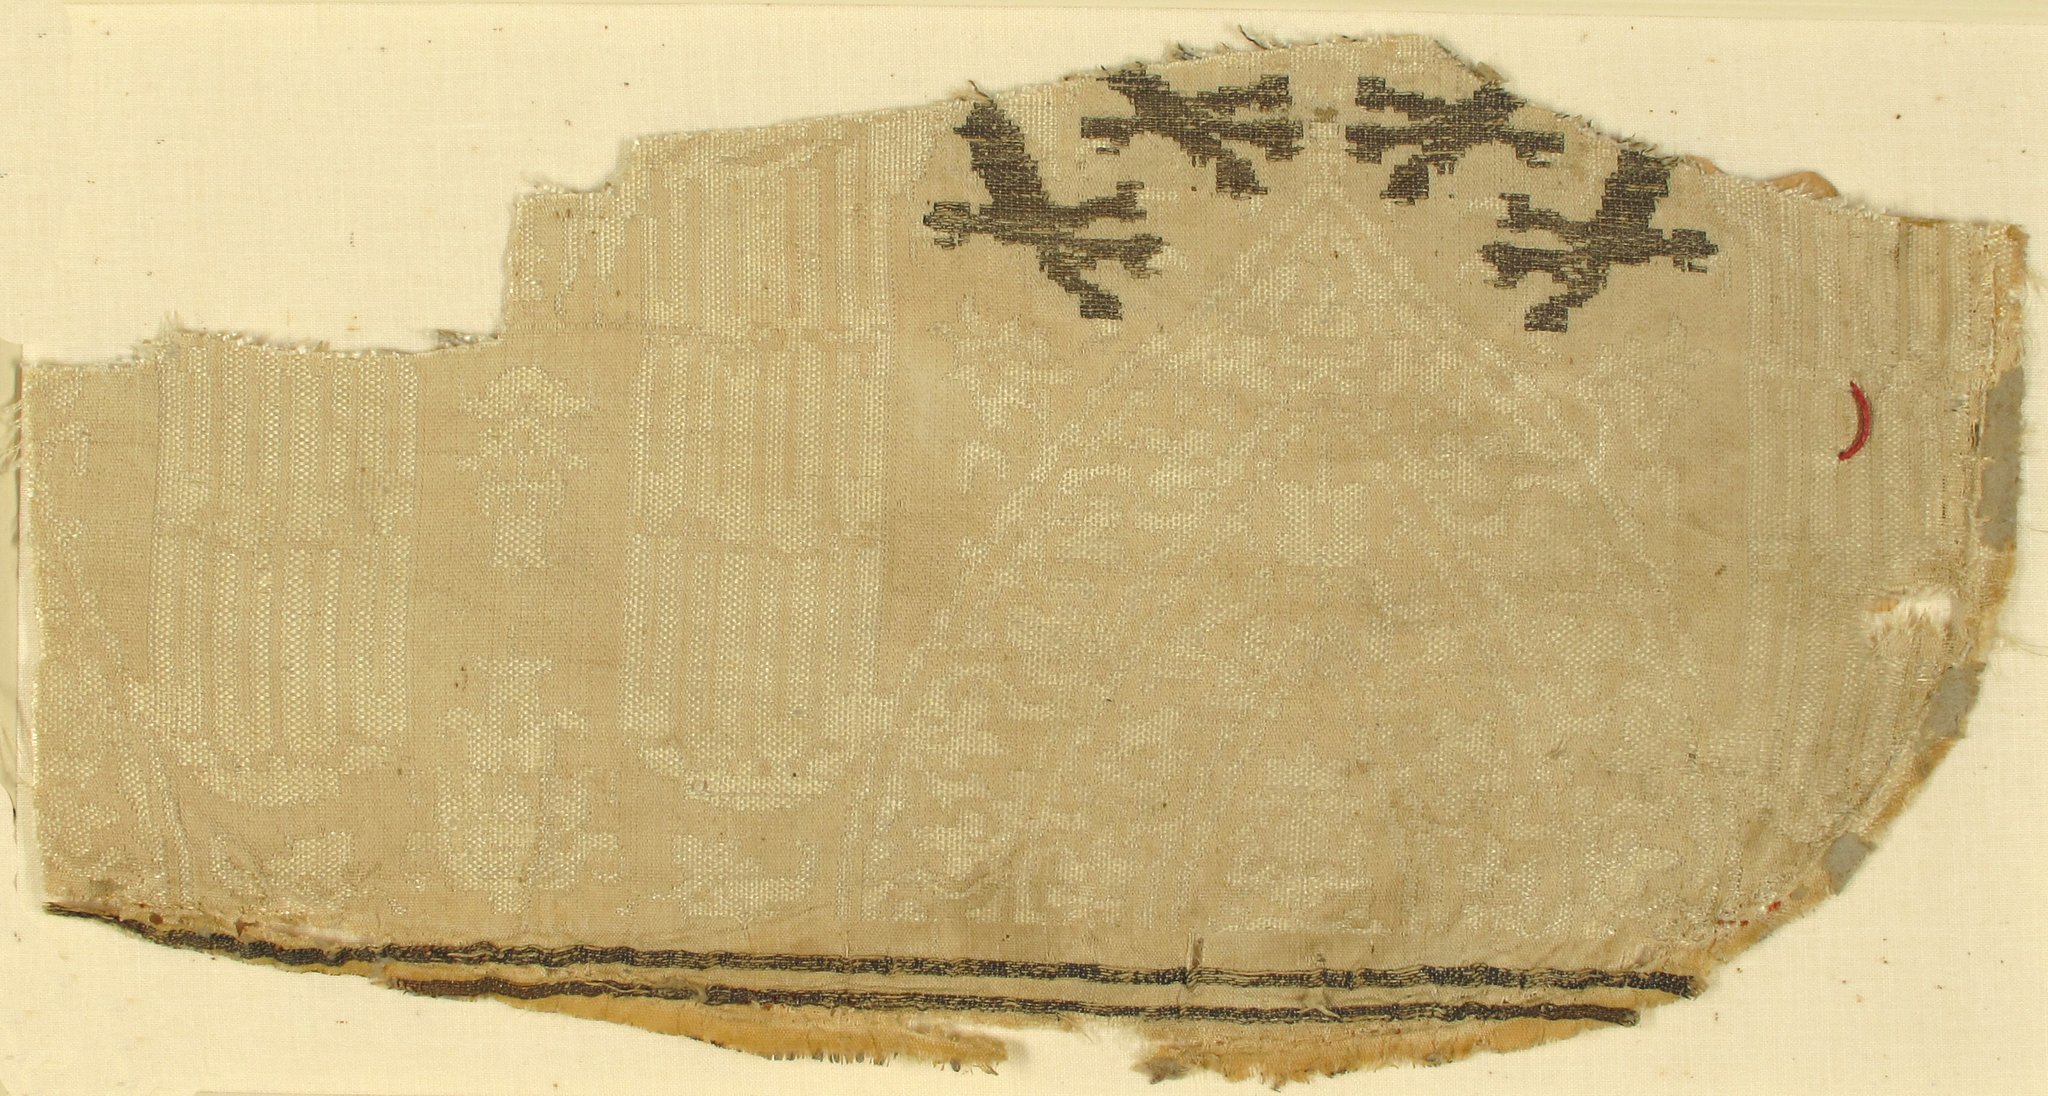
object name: textile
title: Textile with Brocade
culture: italian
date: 1201-1400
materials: linen, metal, thread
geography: italy